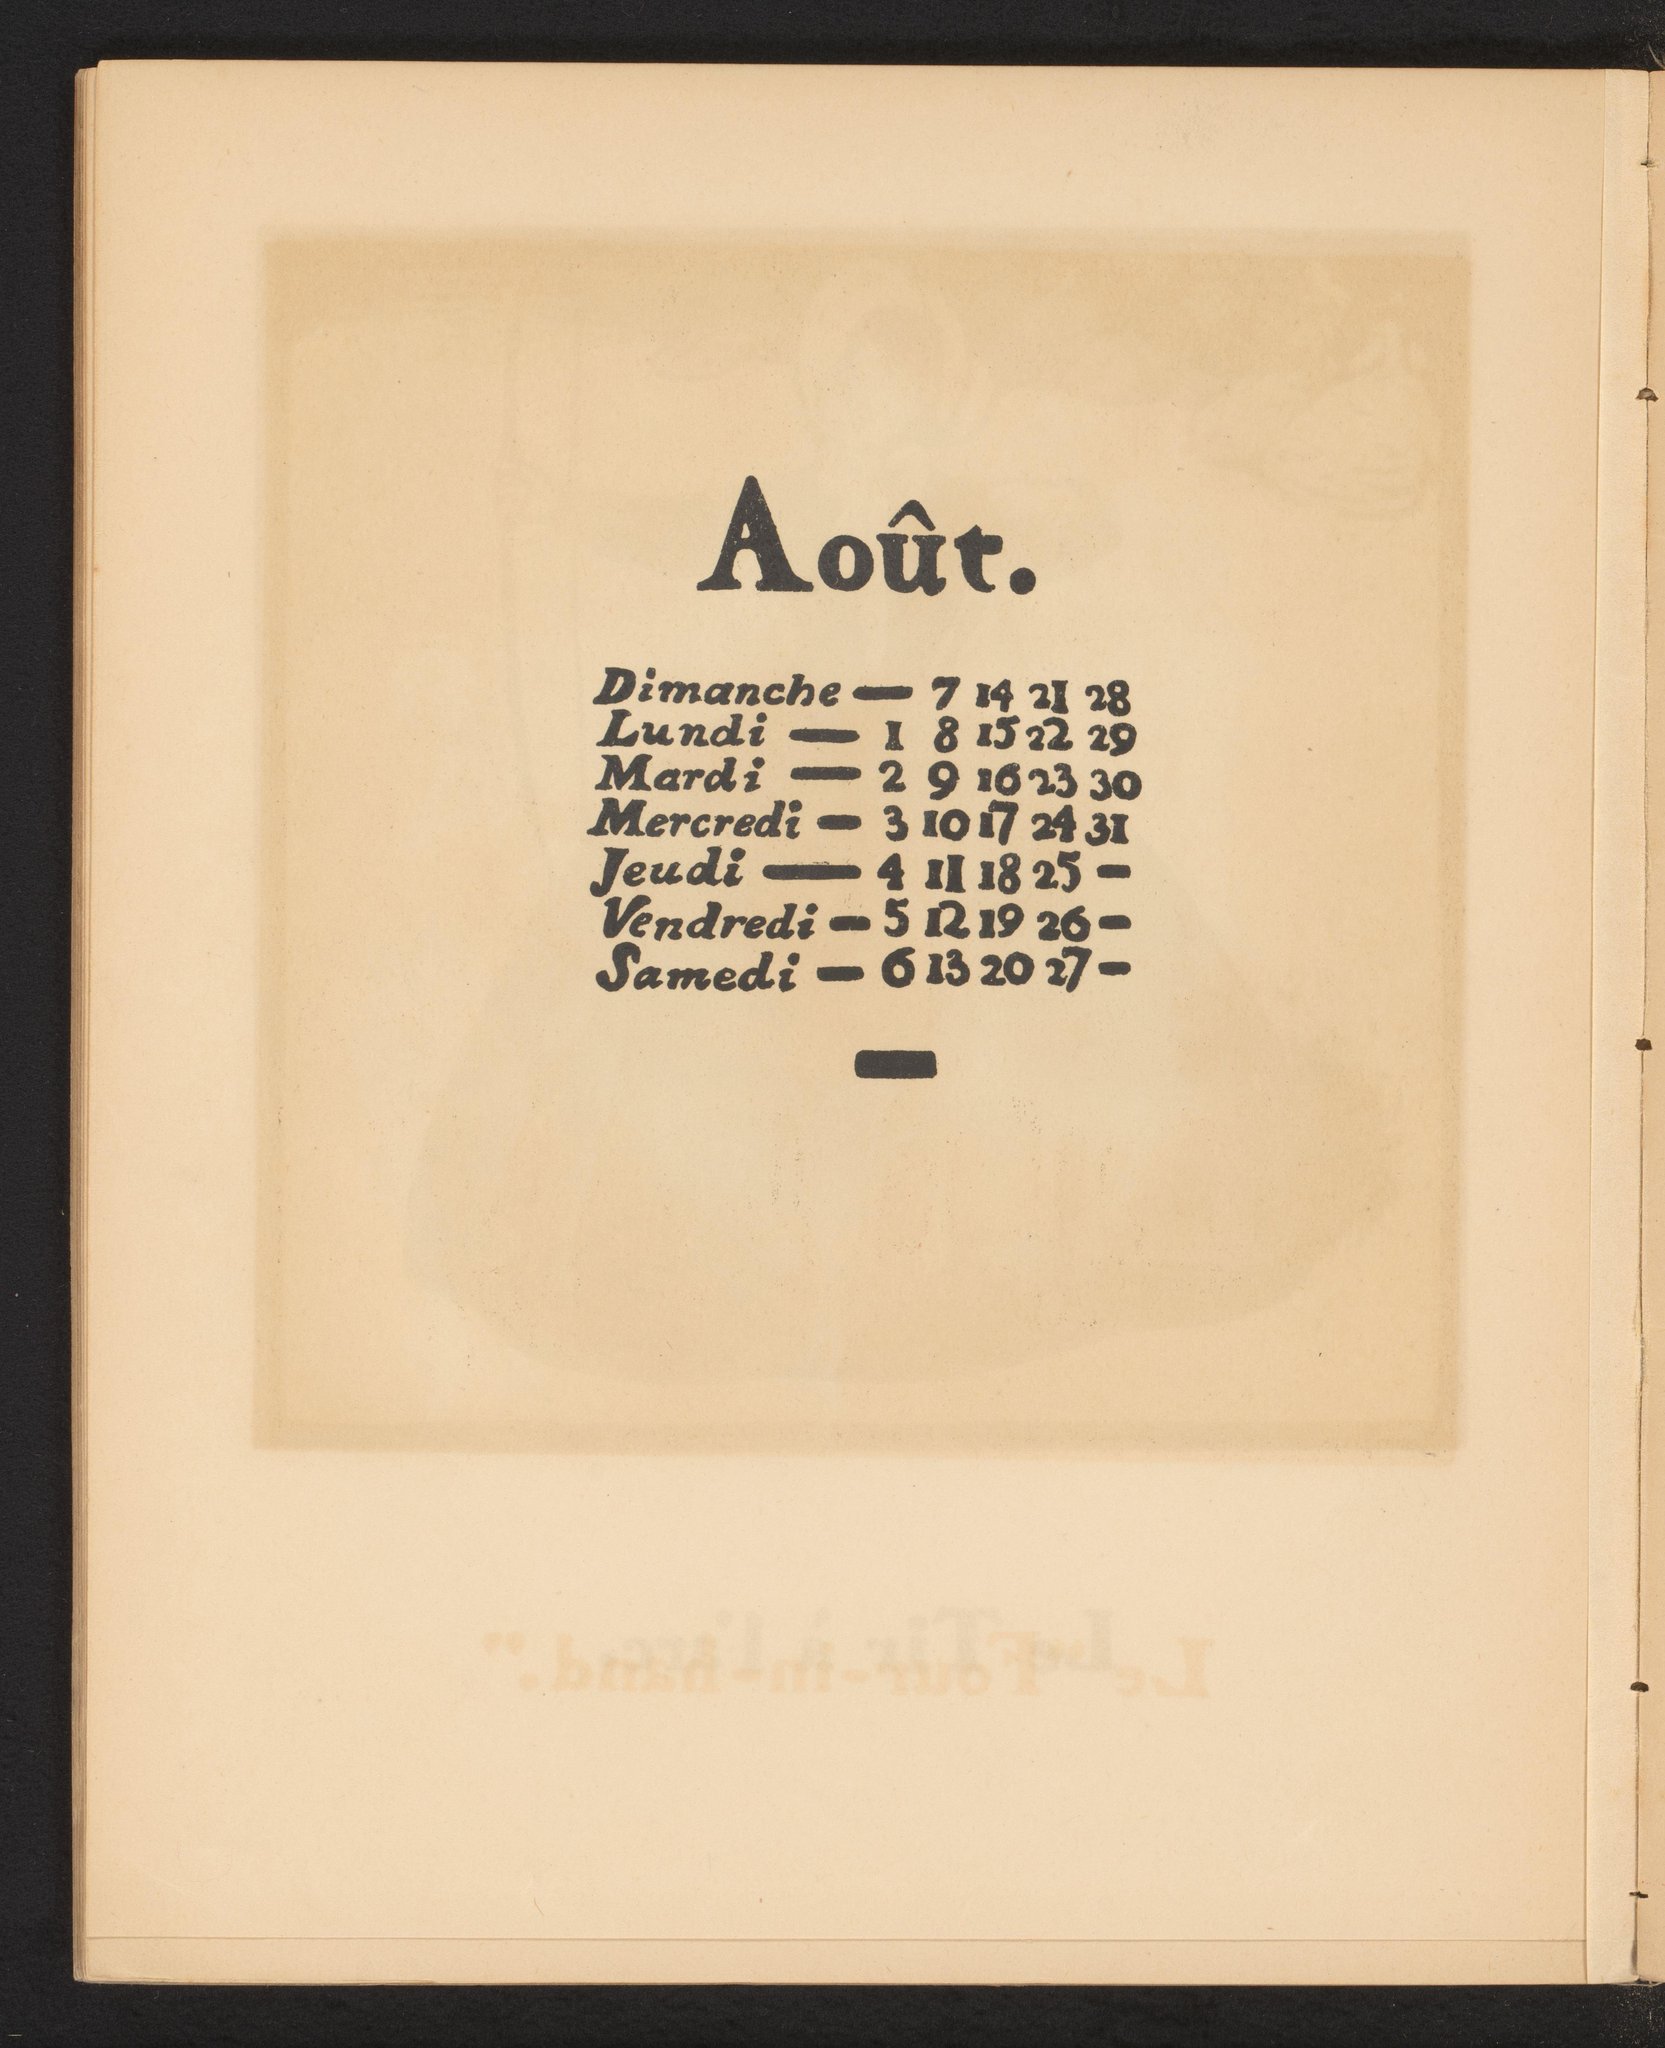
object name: page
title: Augustus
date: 1898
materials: paper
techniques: lithograph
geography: paris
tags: august ~ other concepts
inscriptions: : ‘Ouût./ Dimanche - 7 14 21 28/ Lundi 1 8 15 (...)’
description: Kalendermaand bij de illustratie op het tegenoverliggende blad. Prent maakt deel uit van een boek.